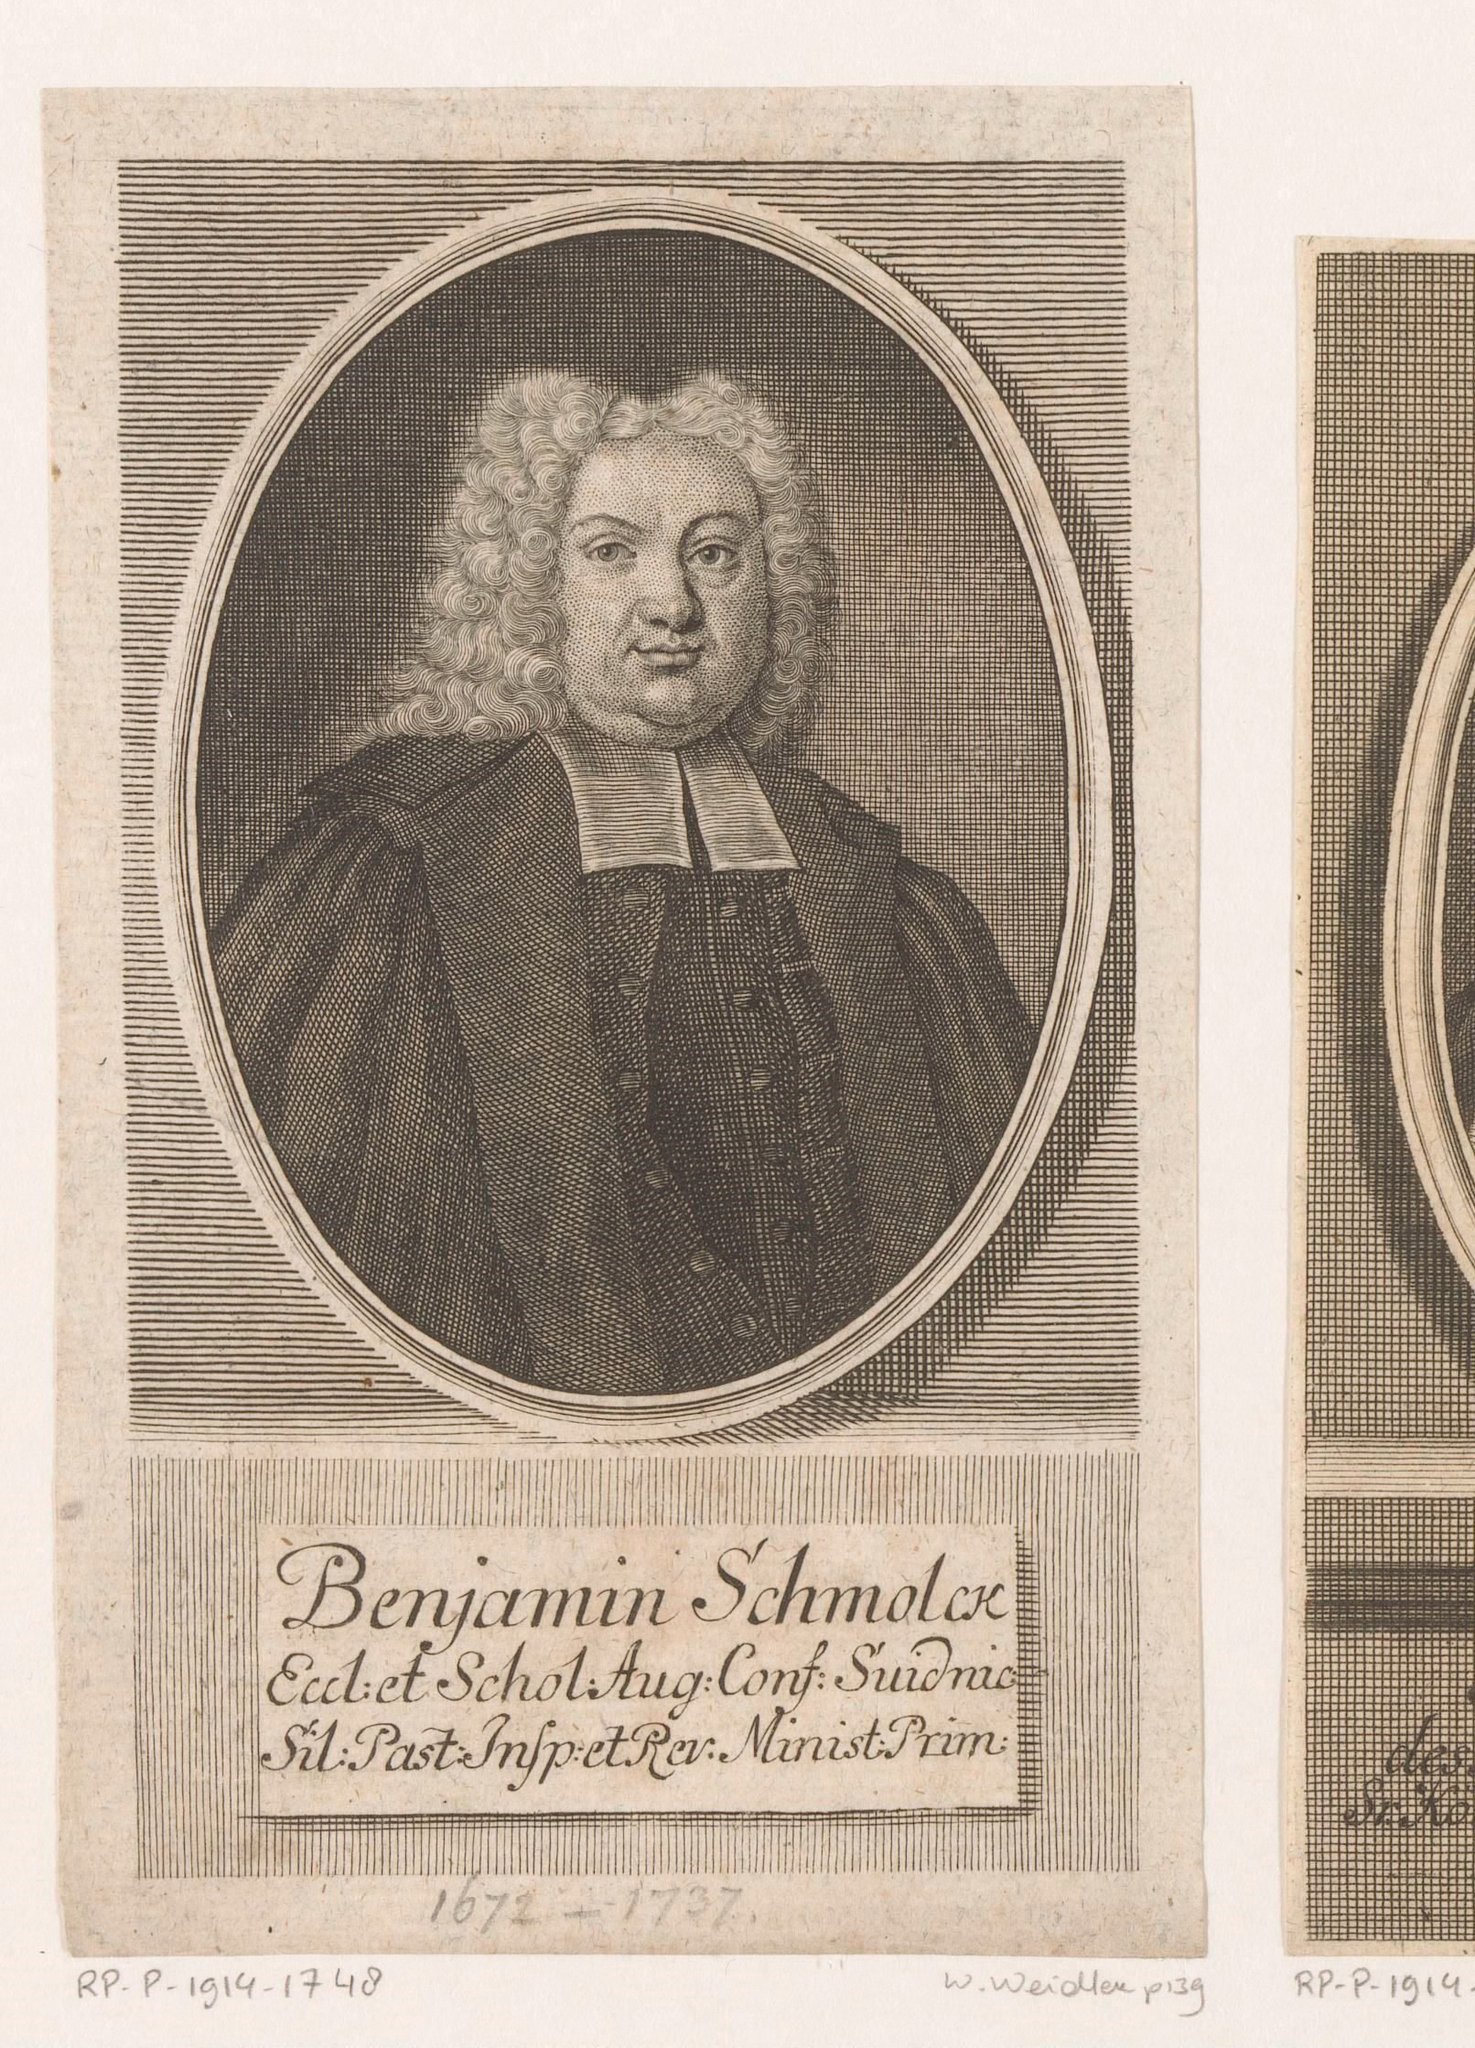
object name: print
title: Portret van Benjamin Schmolck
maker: johann martin bernigeroth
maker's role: print maker, publisher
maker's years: 1713-1767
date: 1736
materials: paper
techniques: engraving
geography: leipzig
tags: historical persons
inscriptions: collector's mark: Lugt 2228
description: Prent ook gebruikt in: Deutsche Acta Eruditorum (...). dl. 203 Leipzig: Johann Gottlieb Gleditsch, 1736.